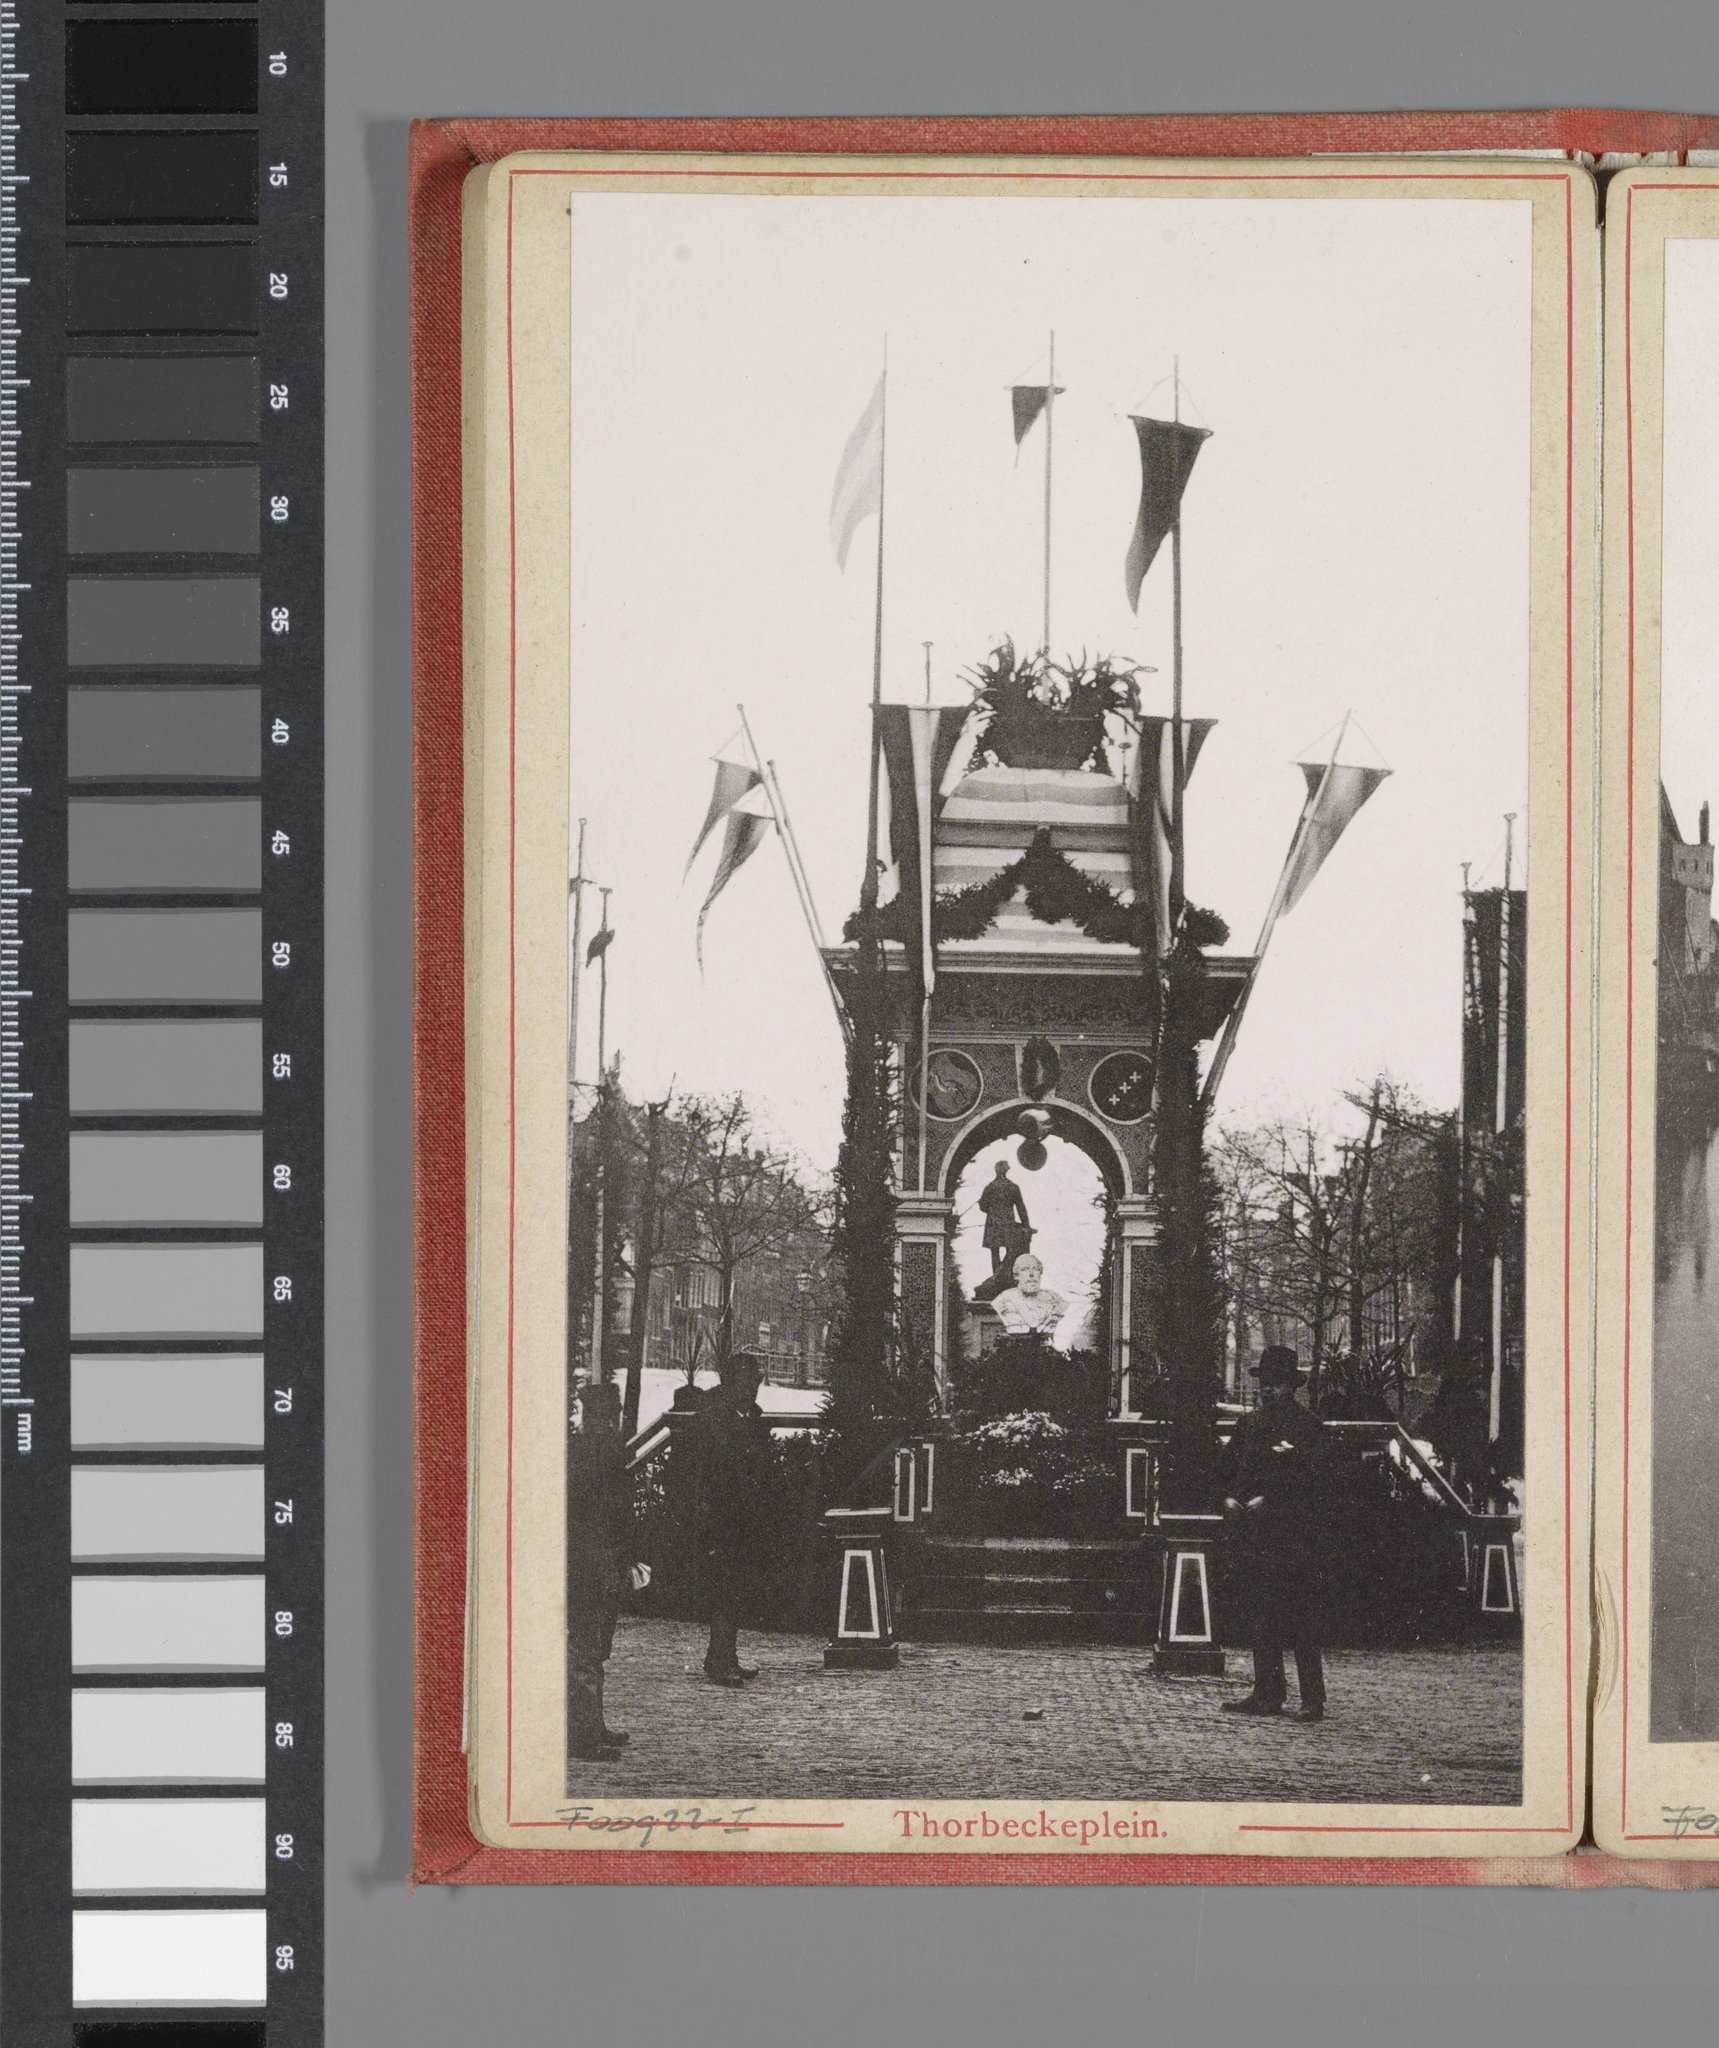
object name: photograph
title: Tijdelijk monument op het Thorbeckeplein tijdens de Aprilfeesten in 1887 te Amsterdam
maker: Anonymous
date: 1804-1887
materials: cardboard, paper, ink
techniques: photograph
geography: amsterdam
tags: monument, statue, prospect of city, town panorama, silhouette of city, amsterdam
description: Onderdeel van Fotoalbum met opnames van de Aprilfeesten in 1887 te Amsterdam.